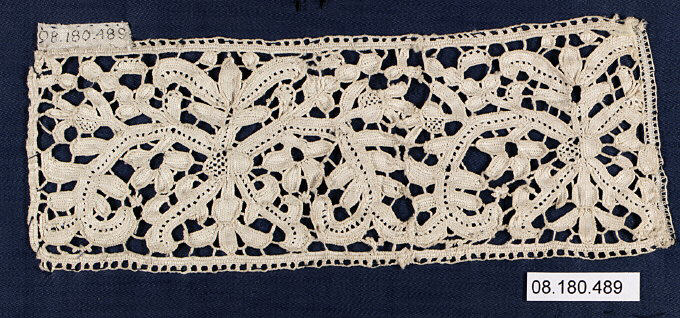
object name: cuff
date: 1601-1700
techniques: lace